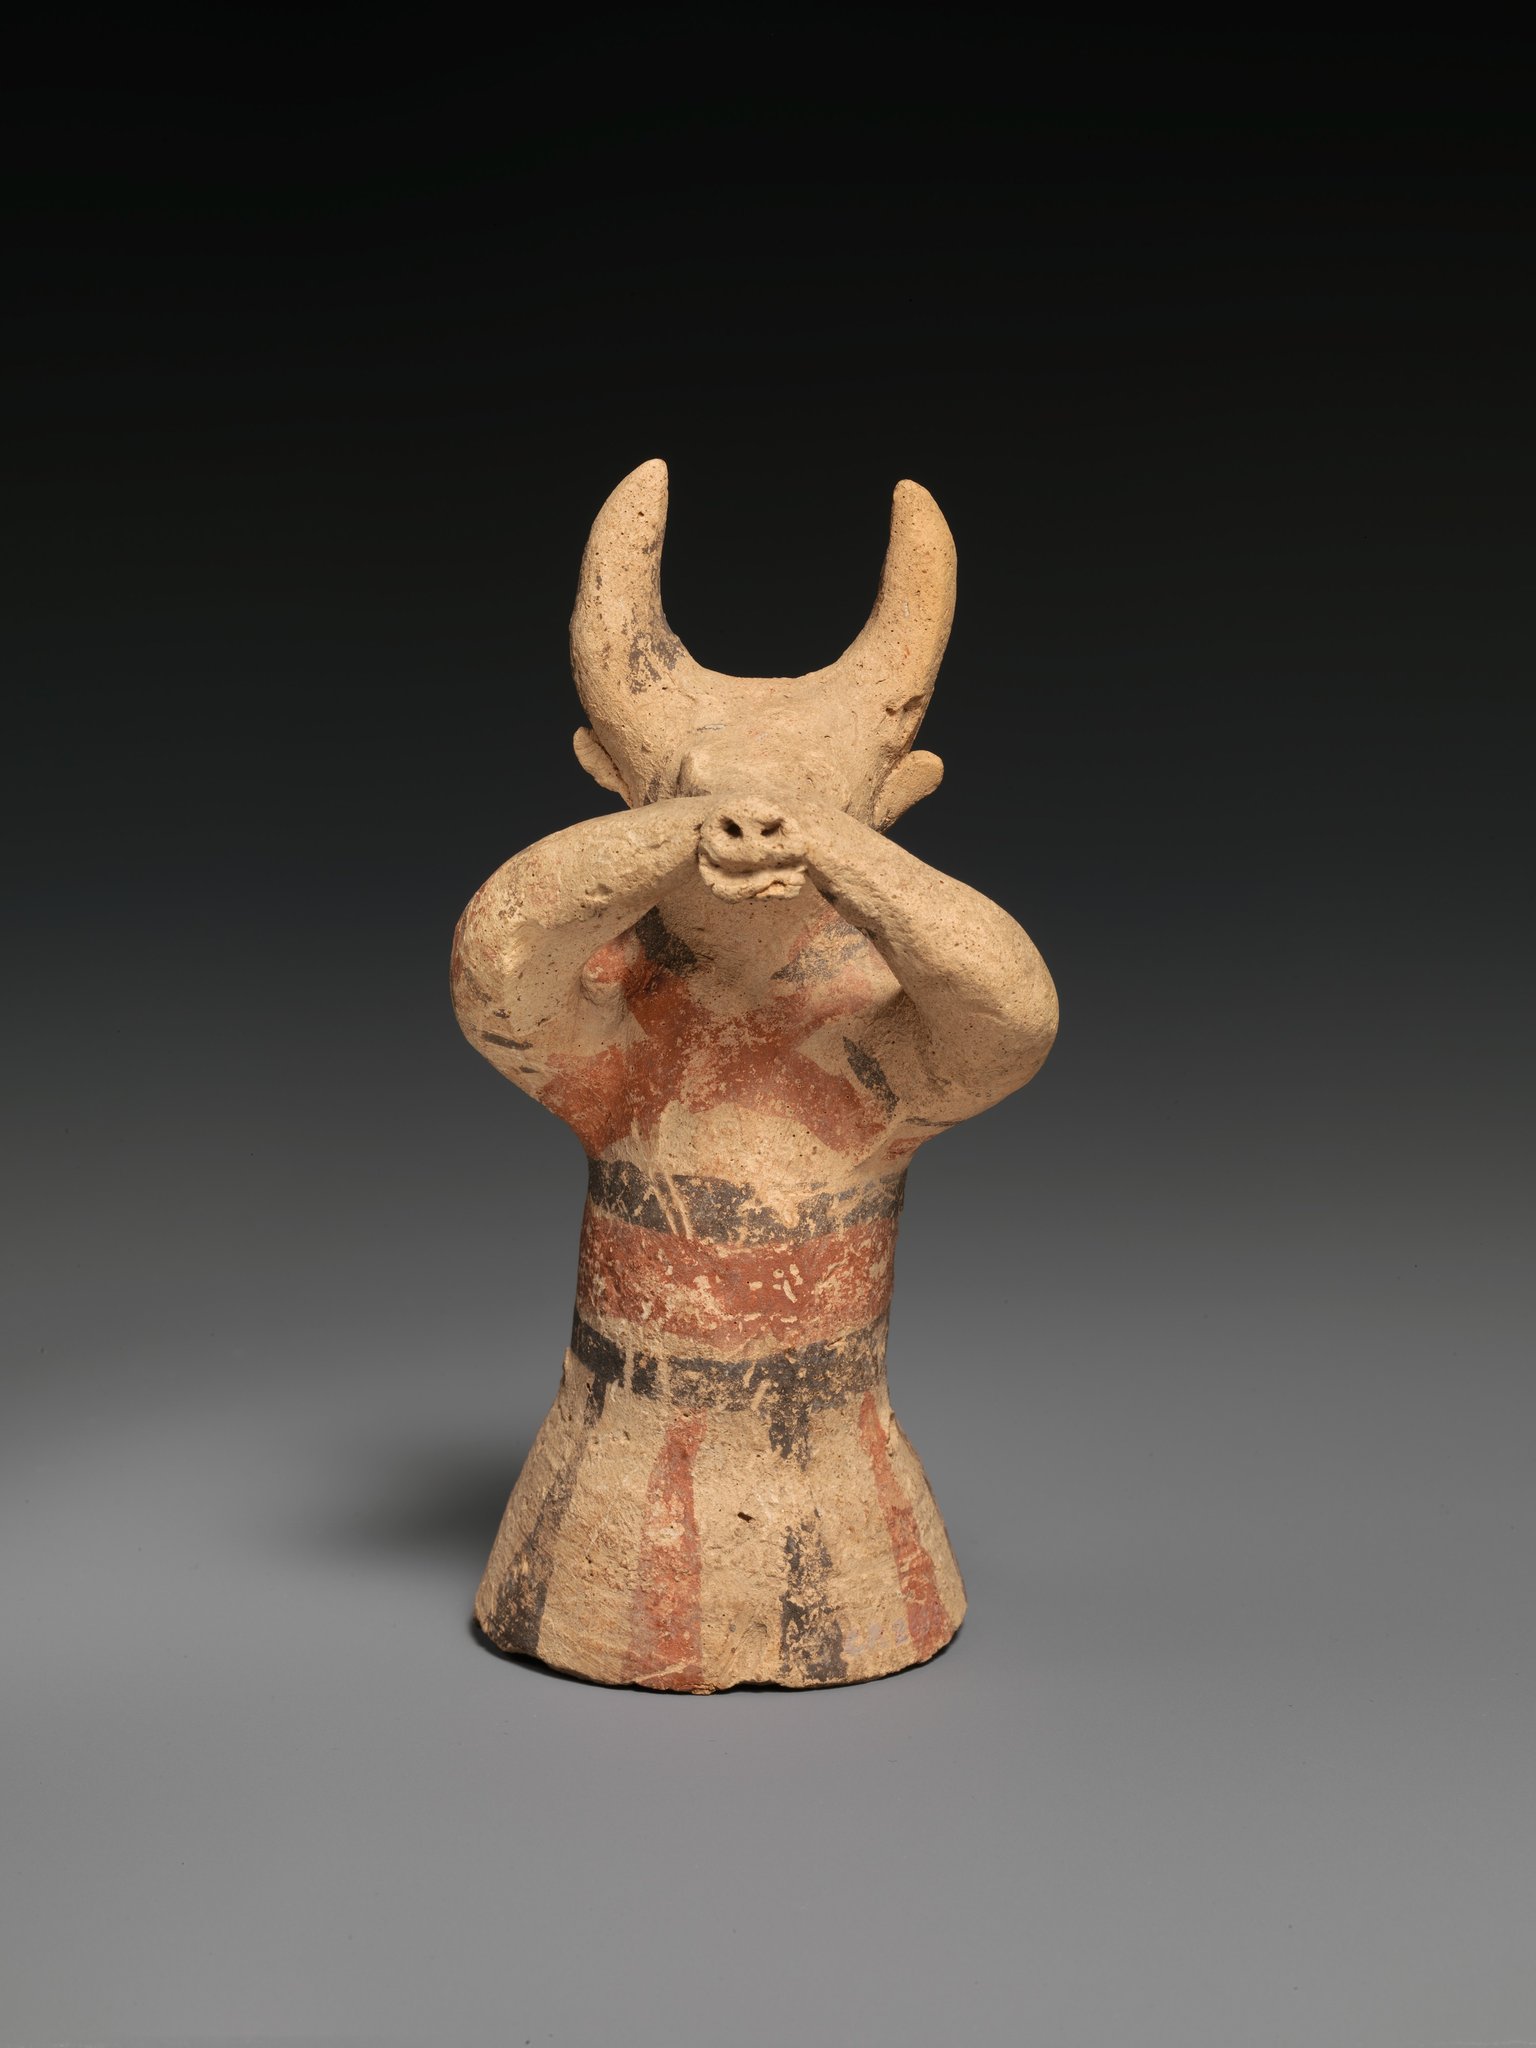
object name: figurine wearing a bull mask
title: Terracotta figure wearing a bull mask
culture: cypriot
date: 750-600 BCE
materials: terracotta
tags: human figures,masks,bulls